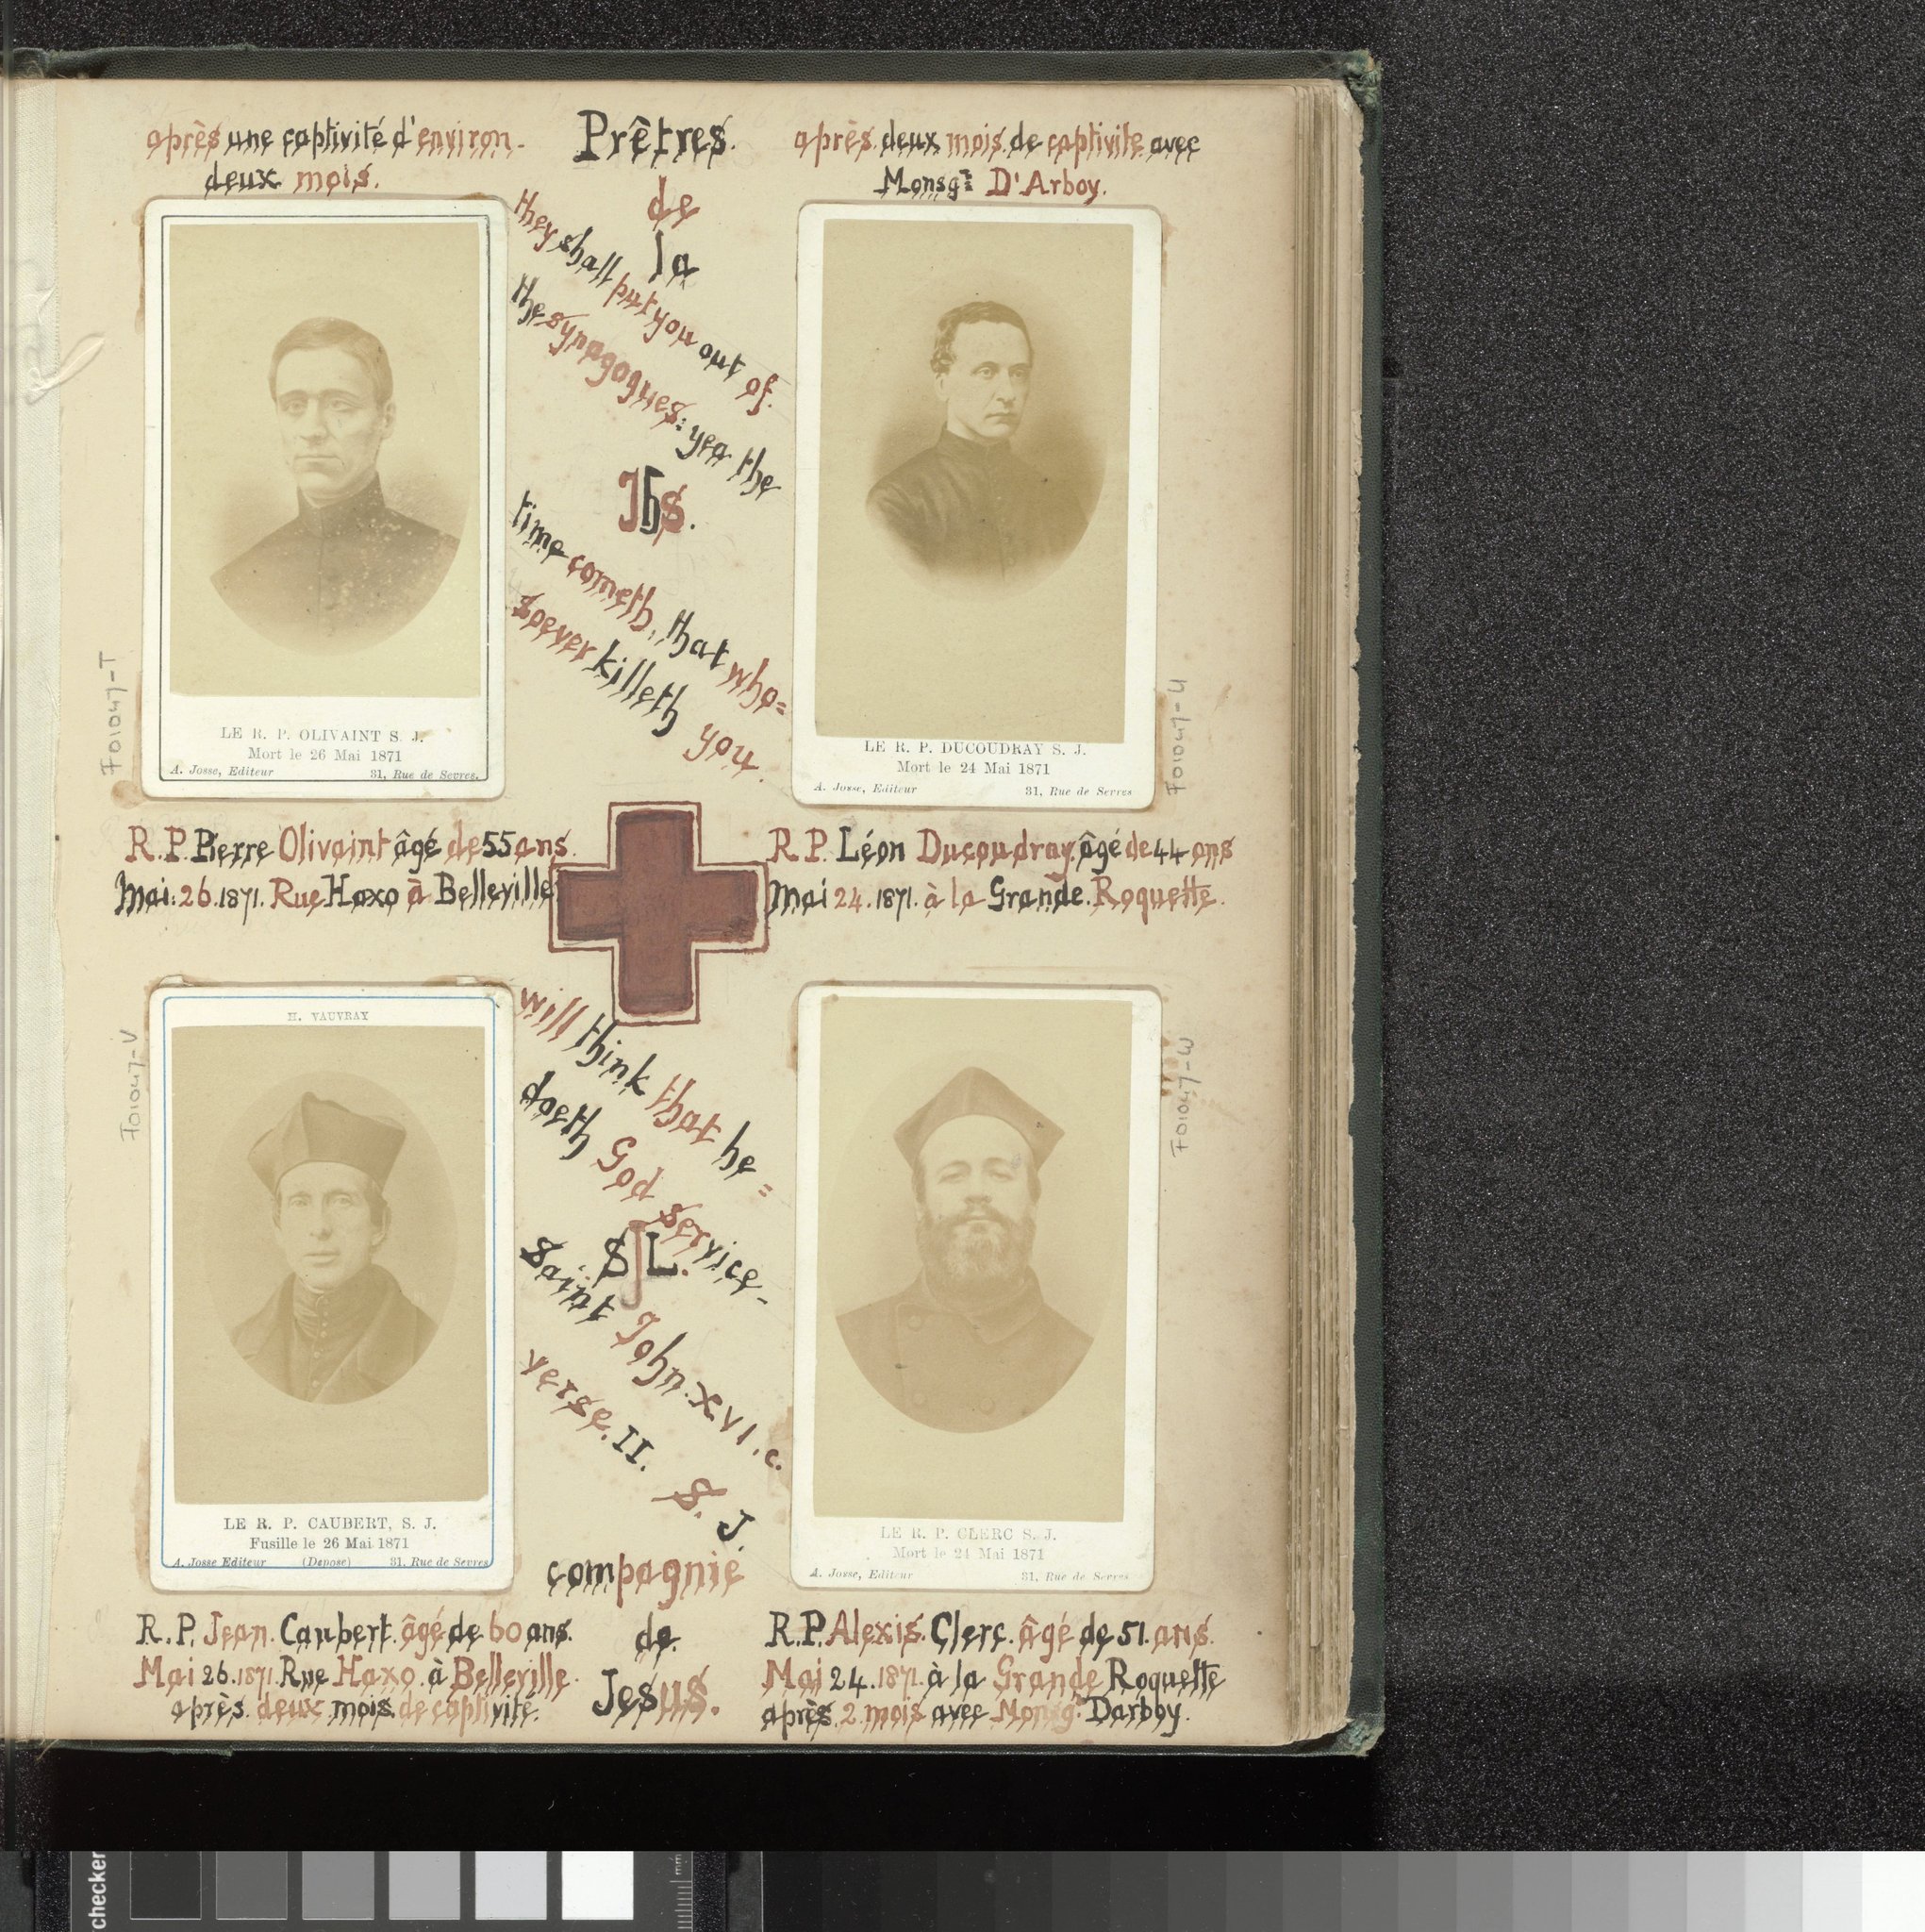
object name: carte de visite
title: Portret van R.P. Ducoudray S.J.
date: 1871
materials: cardboard, paper, photographic support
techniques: albumen print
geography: paris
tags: priest (roman catholic)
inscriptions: address: ‘31, Rue de Sevres’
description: Onderdeel van Herdenkingsalbum van rooms-katholieke geestelijken gevallen tijdens de Commune van Parijs.